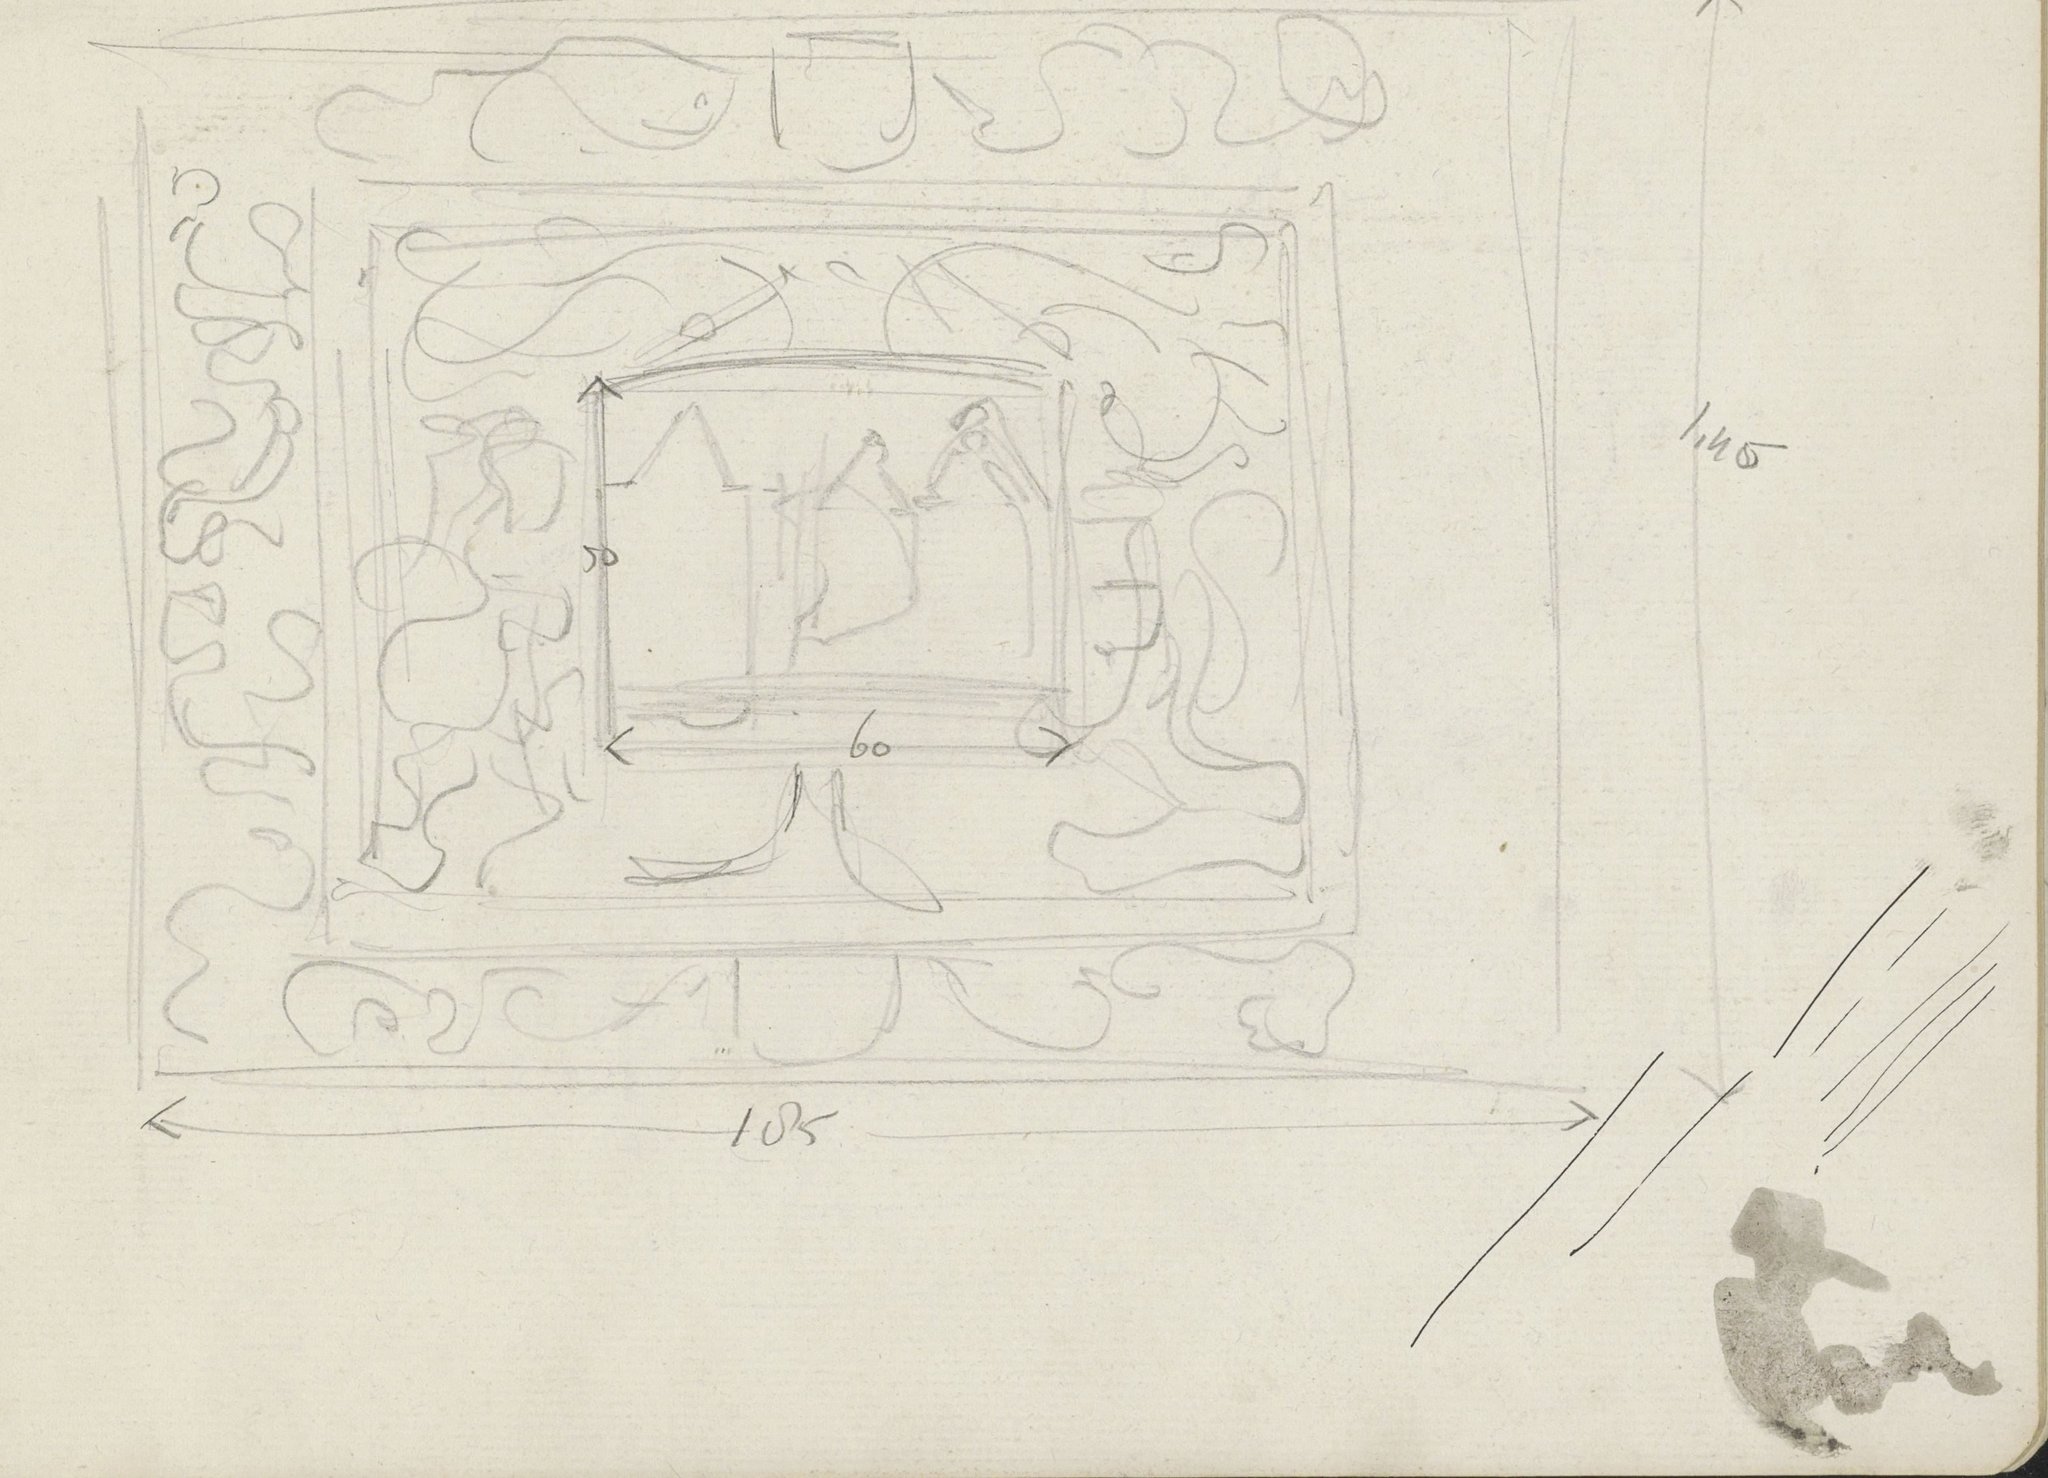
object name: sketchbook leaf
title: Ontwerp voor de firma B.H. Manus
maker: carel adolph lion cachet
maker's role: draughtsman, print maker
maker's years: 1864-1945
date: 1905-1910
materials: paper, pencil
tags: ornaments ~ art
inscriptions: annotation: ‘148/ 185’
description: Het ontwerp stelt een aantal gevels voor met daaromheen florale ornamenten. Blad 6 recto uit een schetsboek met 27 bladen.